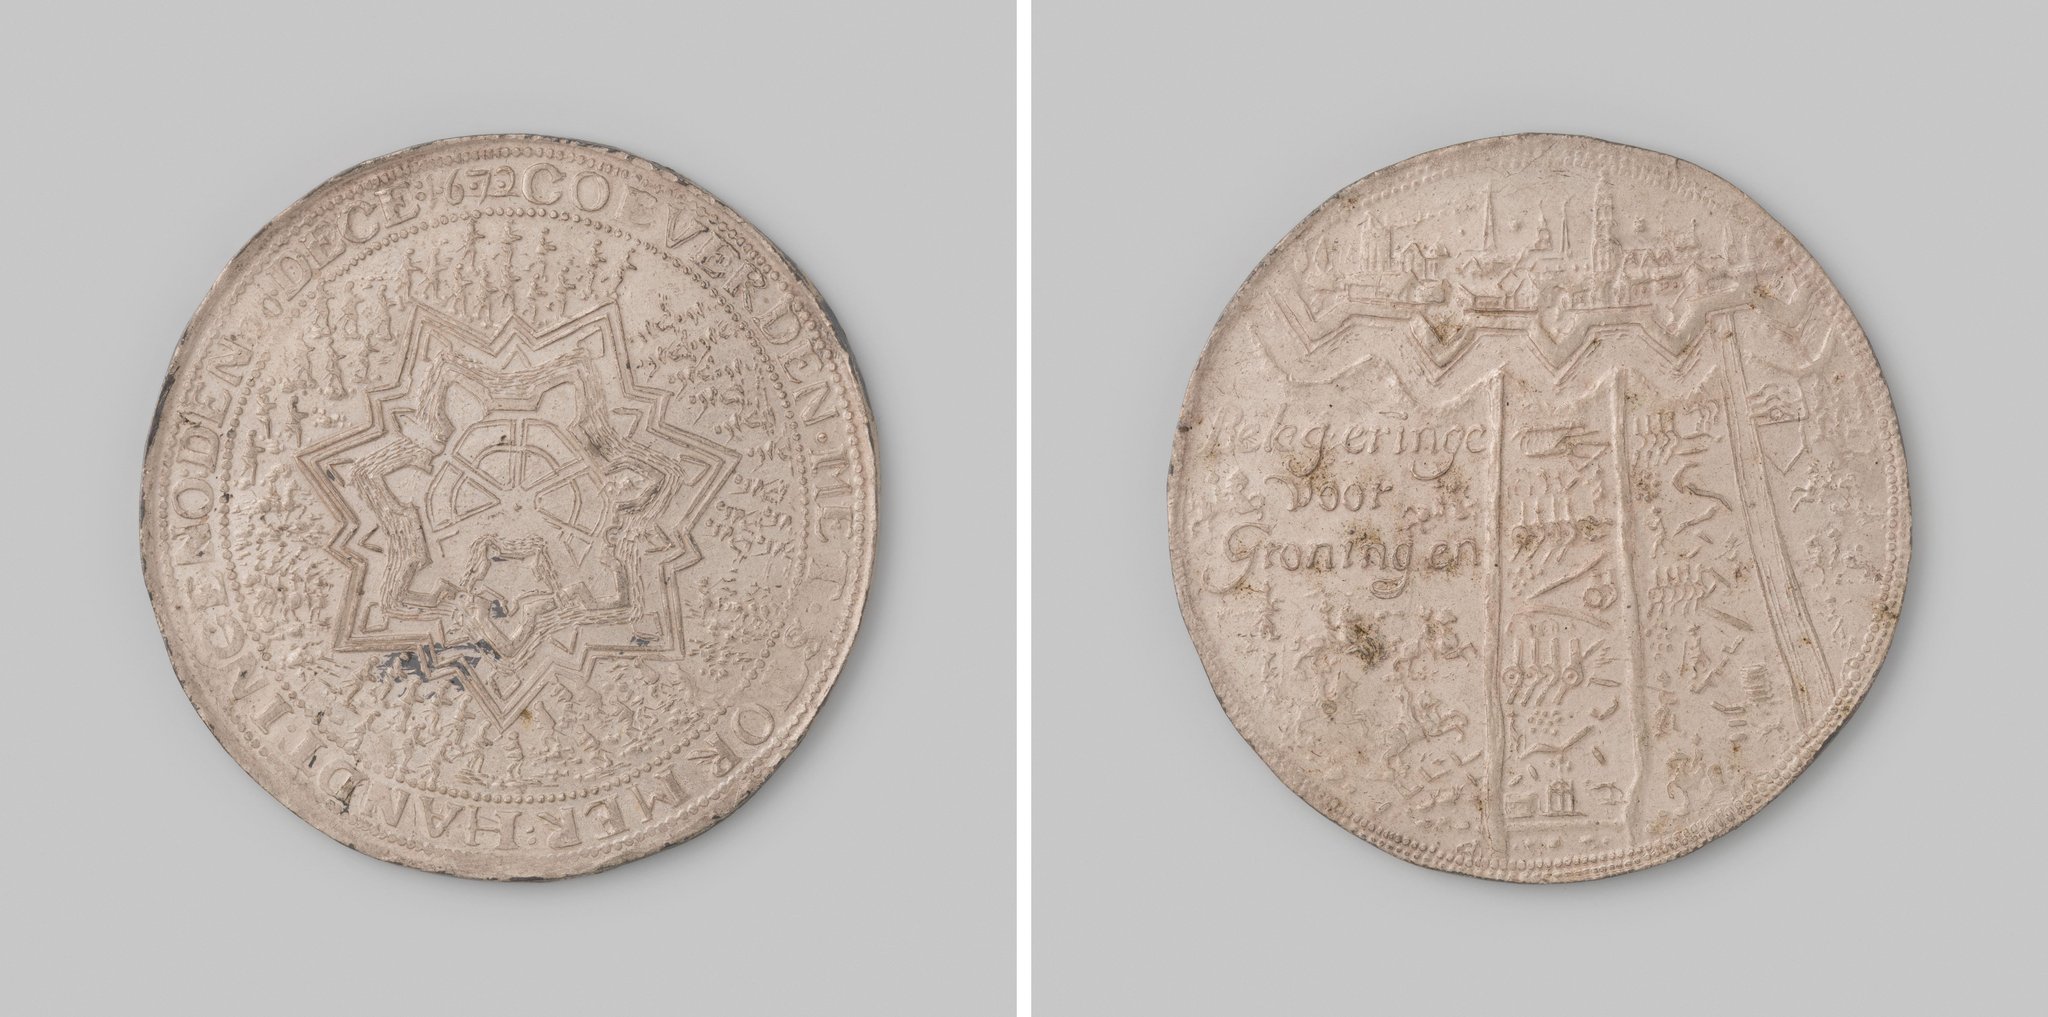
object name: history medal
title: Gedenkpenning van het beleg en ontzet van Groningen en het stormenderhand veroveren van Coevorden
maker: Anonymous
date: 1672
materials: silver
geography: groningen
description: Zilveren gedenkpenning. Voorzijde: afbeelding van het beleg van Groningen met het bijschrift: 'Belegeringe/ voor/ Groningen'. Keerzijde: plattegrond van de vesting Coevorden met rondom de naderende Groninger troepen. Omschrift: COEVORDEN MET STORMER:HANDT INGENO:(MEN) DEN 20 DECE:(MBER) 1672.